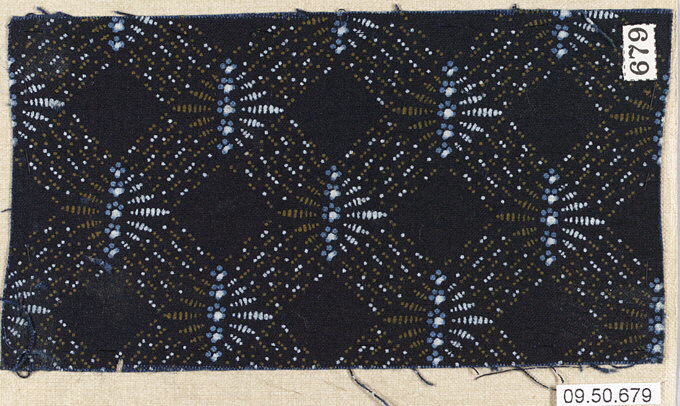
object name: piece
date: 1801-1900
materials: cotton